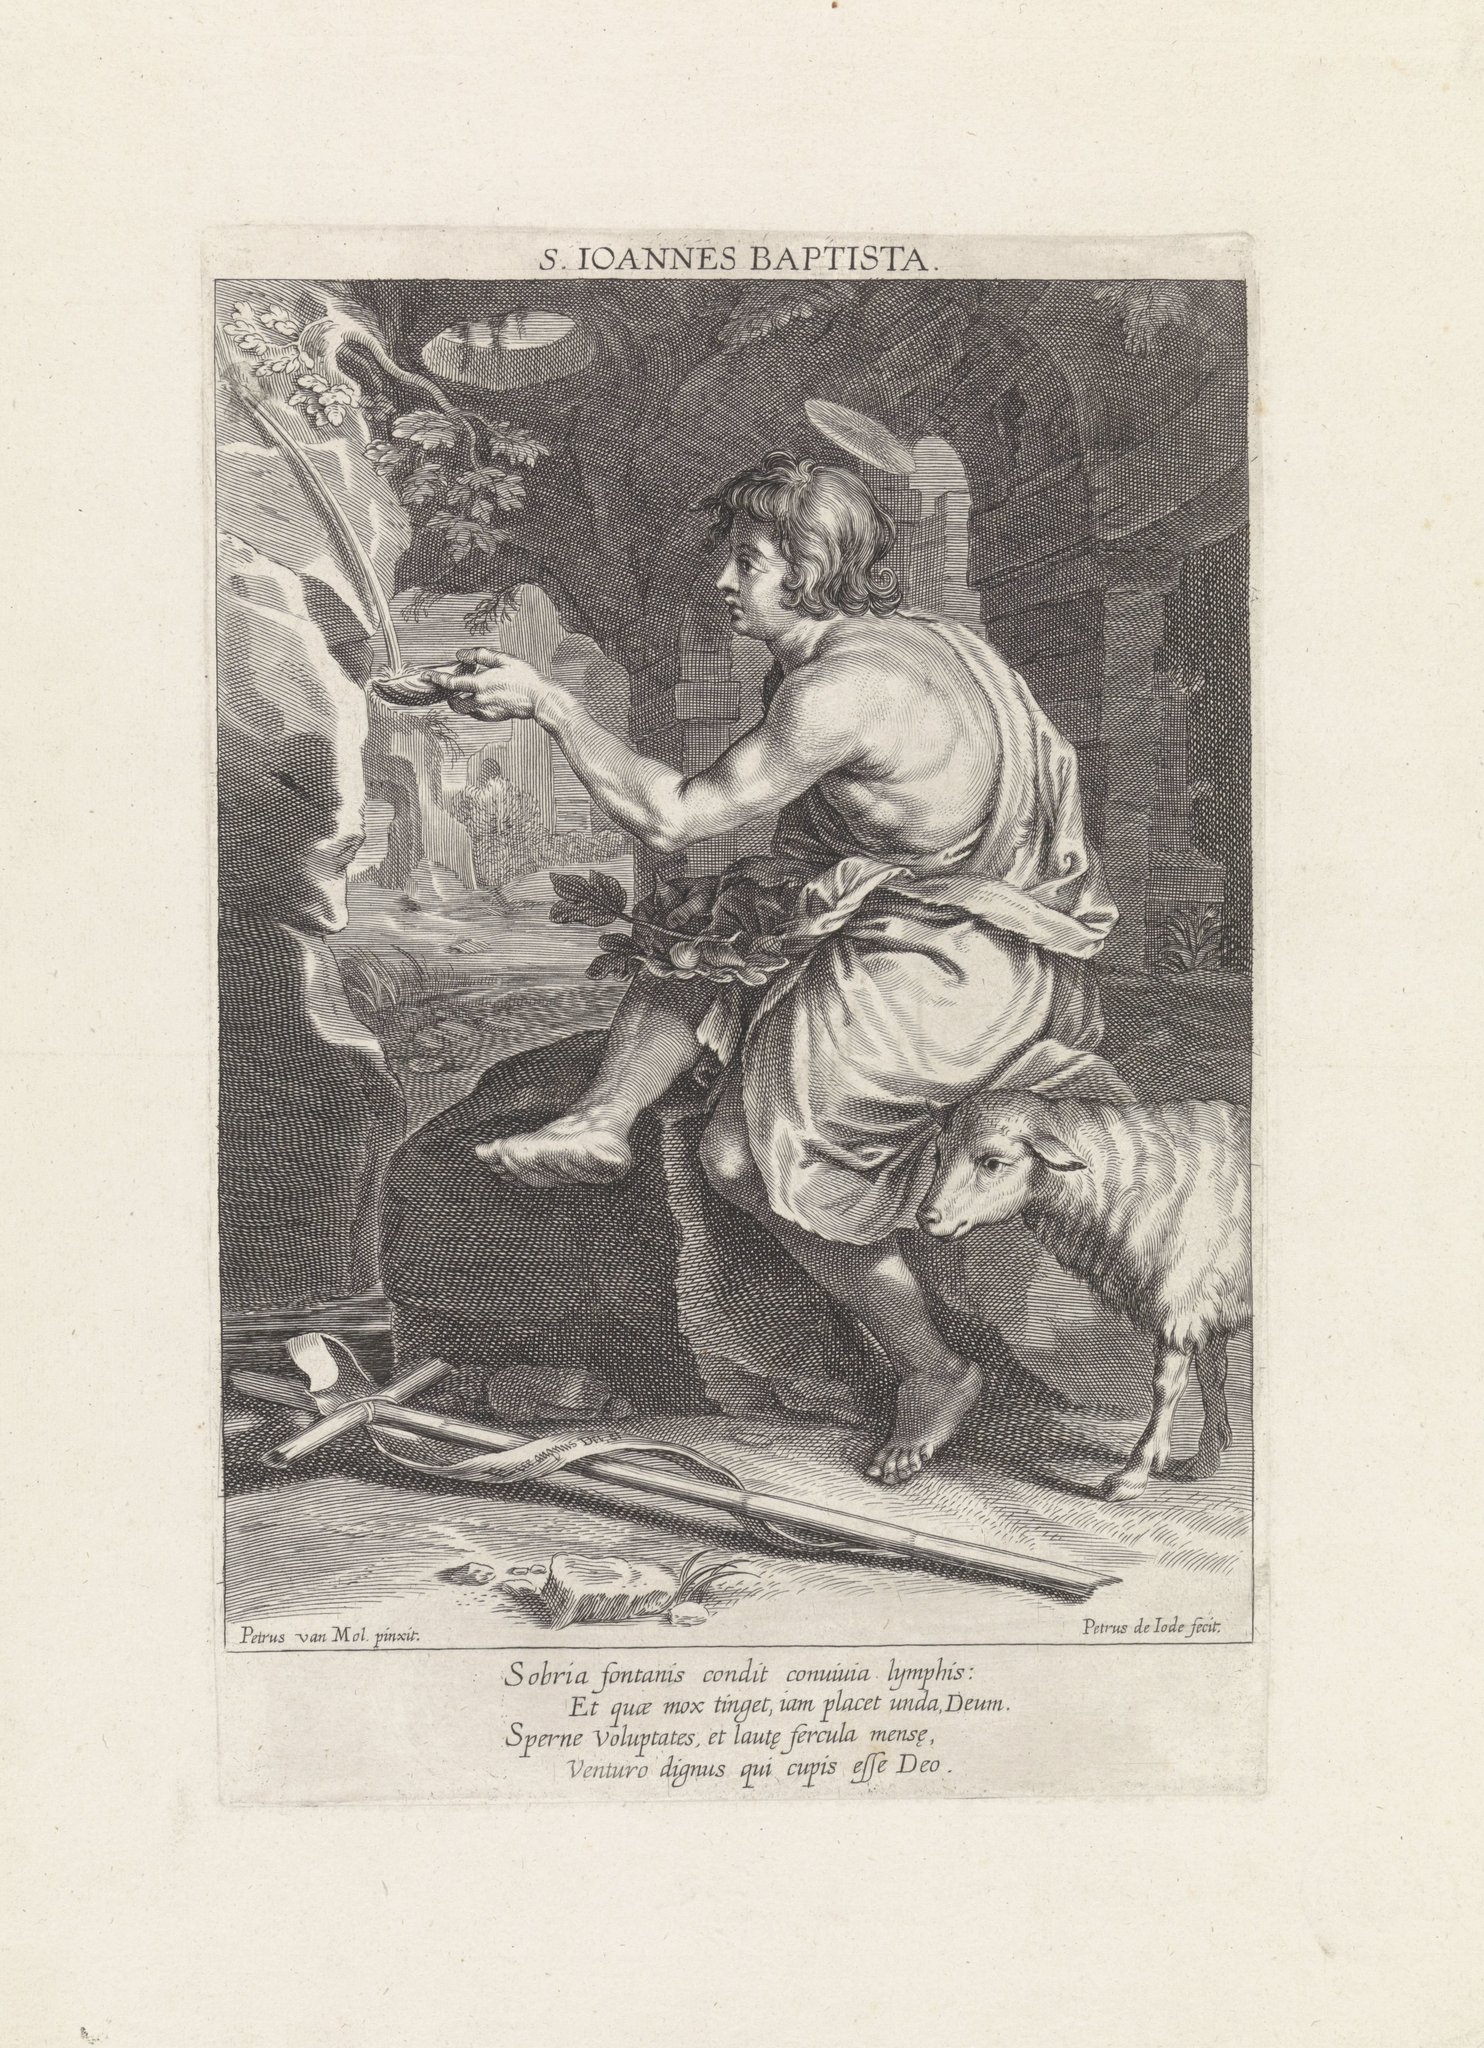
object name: print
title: Johannes de Doper bij bron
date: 1628-1670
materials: paper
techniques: engraving, etching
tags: john the baptist; possible attributes: book, reed cross, baptismal cup, honeycomb, lamb, staff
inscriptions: collector's mark: Lugt 240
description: Johannes de Doper met zijn attributen, zittend bij een bron in een ruïne. Hij vangt water op uit de bron. In de marge een vierregelig onderschrift in het Latijn.